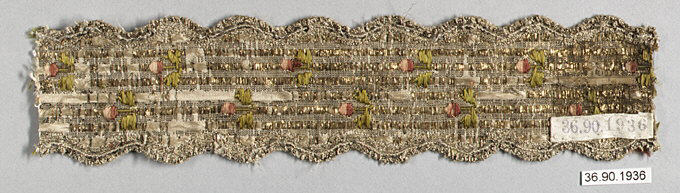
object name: galloon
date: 1701-1800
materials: metal thread, silk